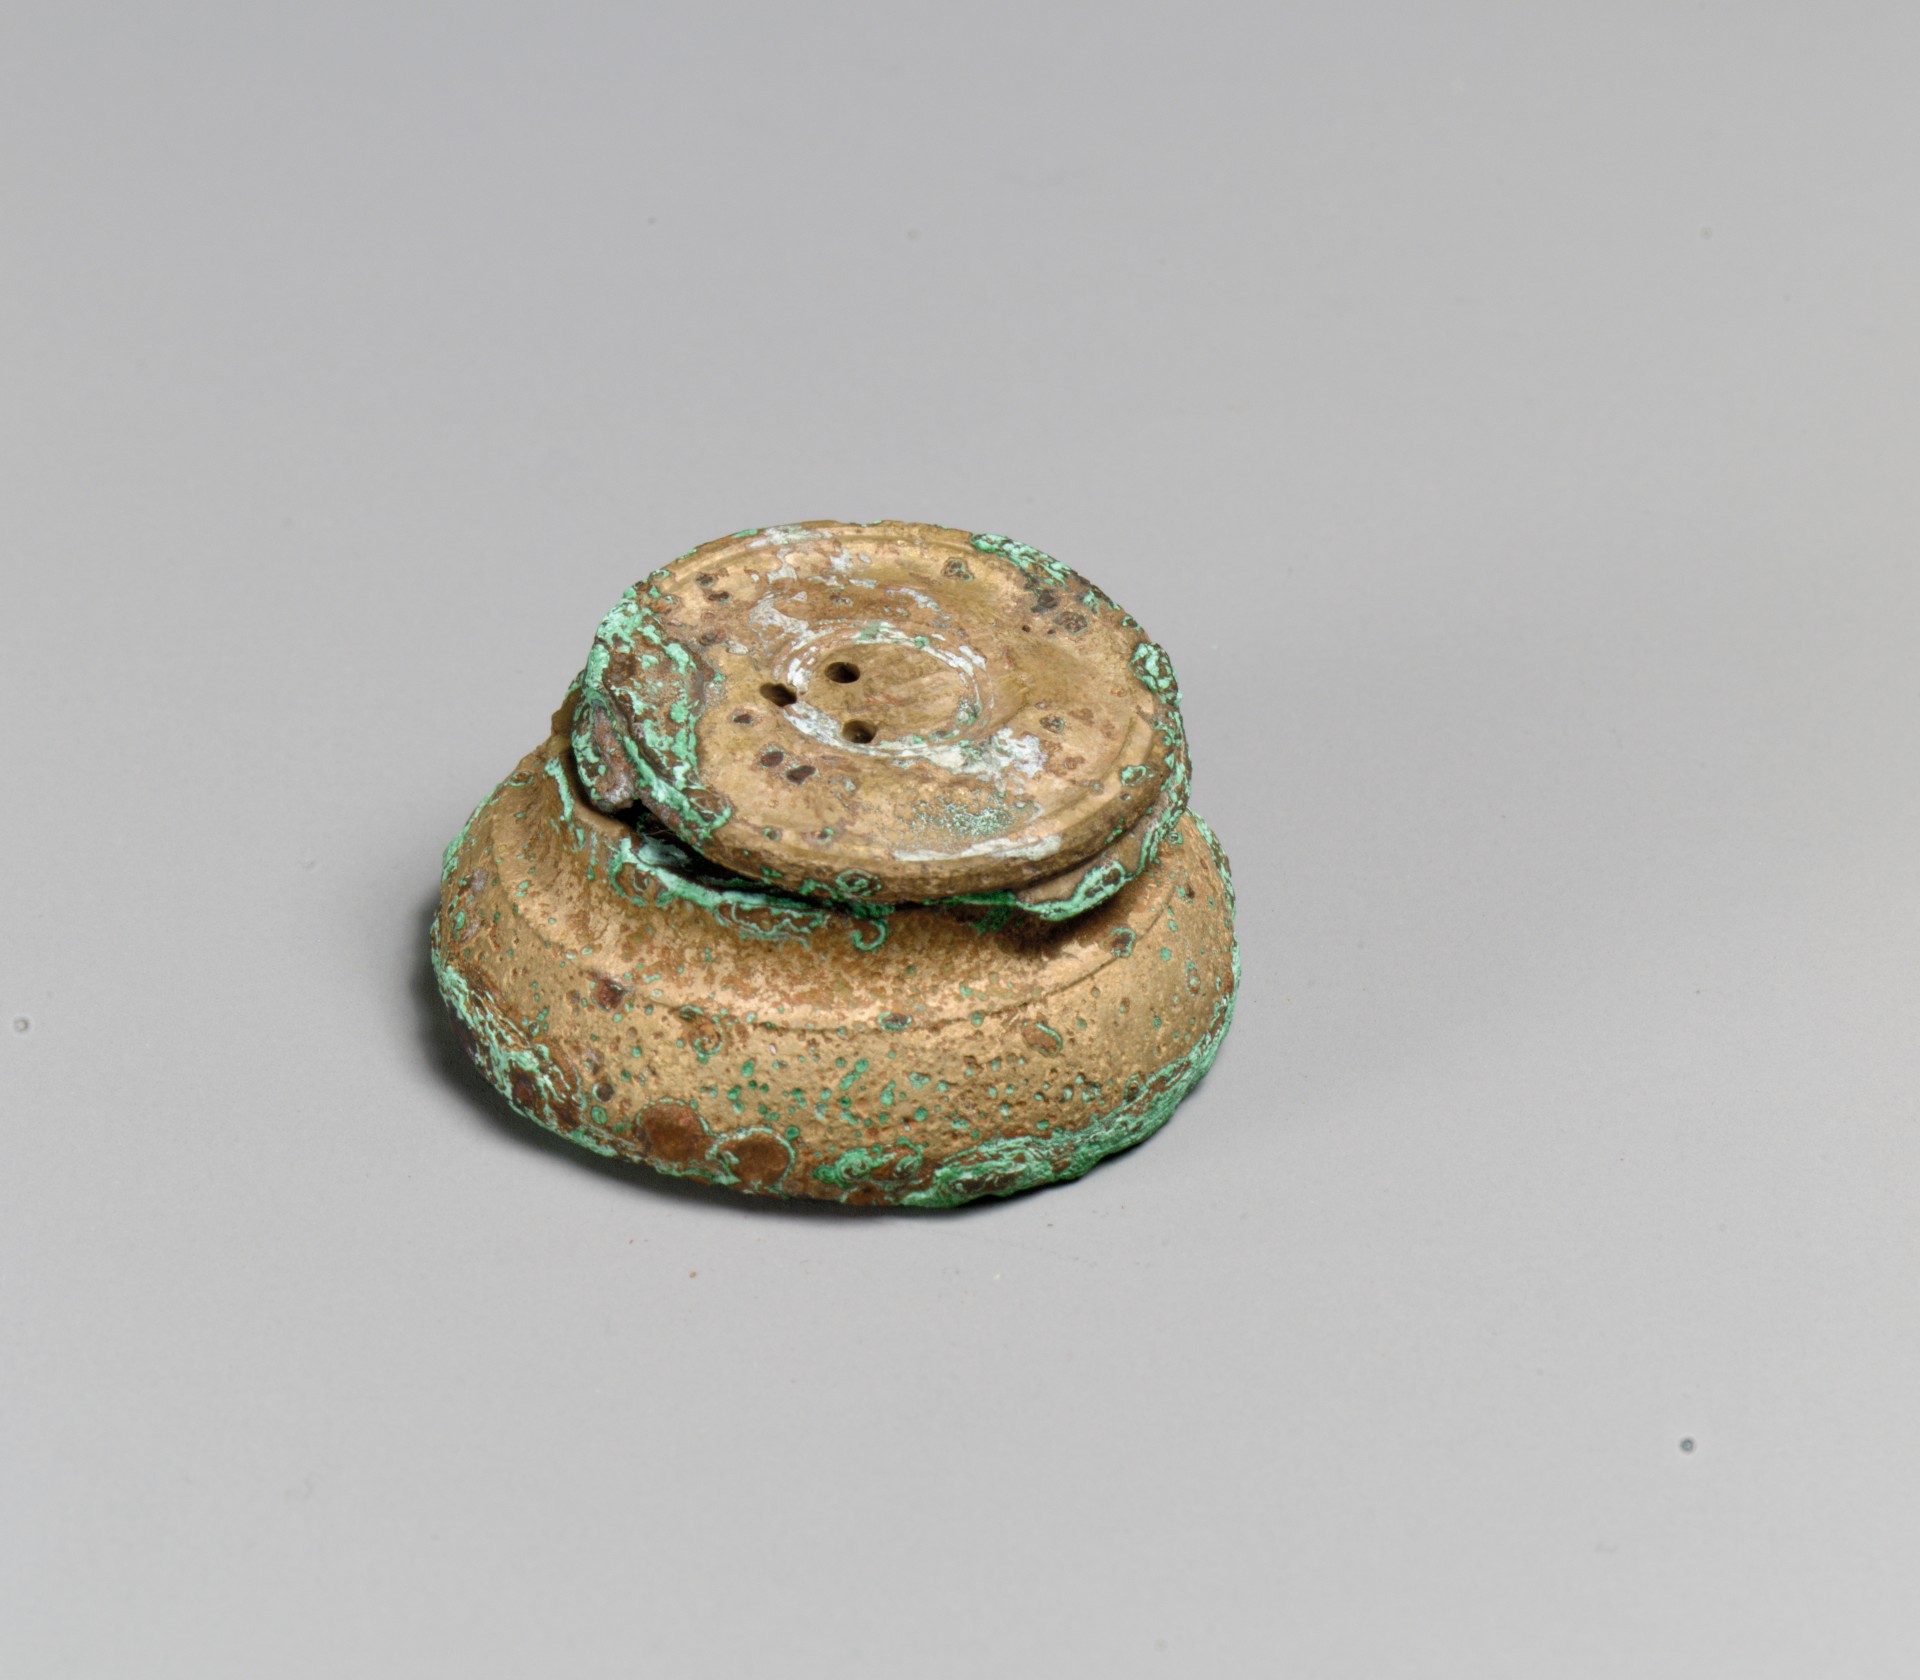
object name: vase base and top of stand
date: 7000 BCE-330 CE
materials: bronze